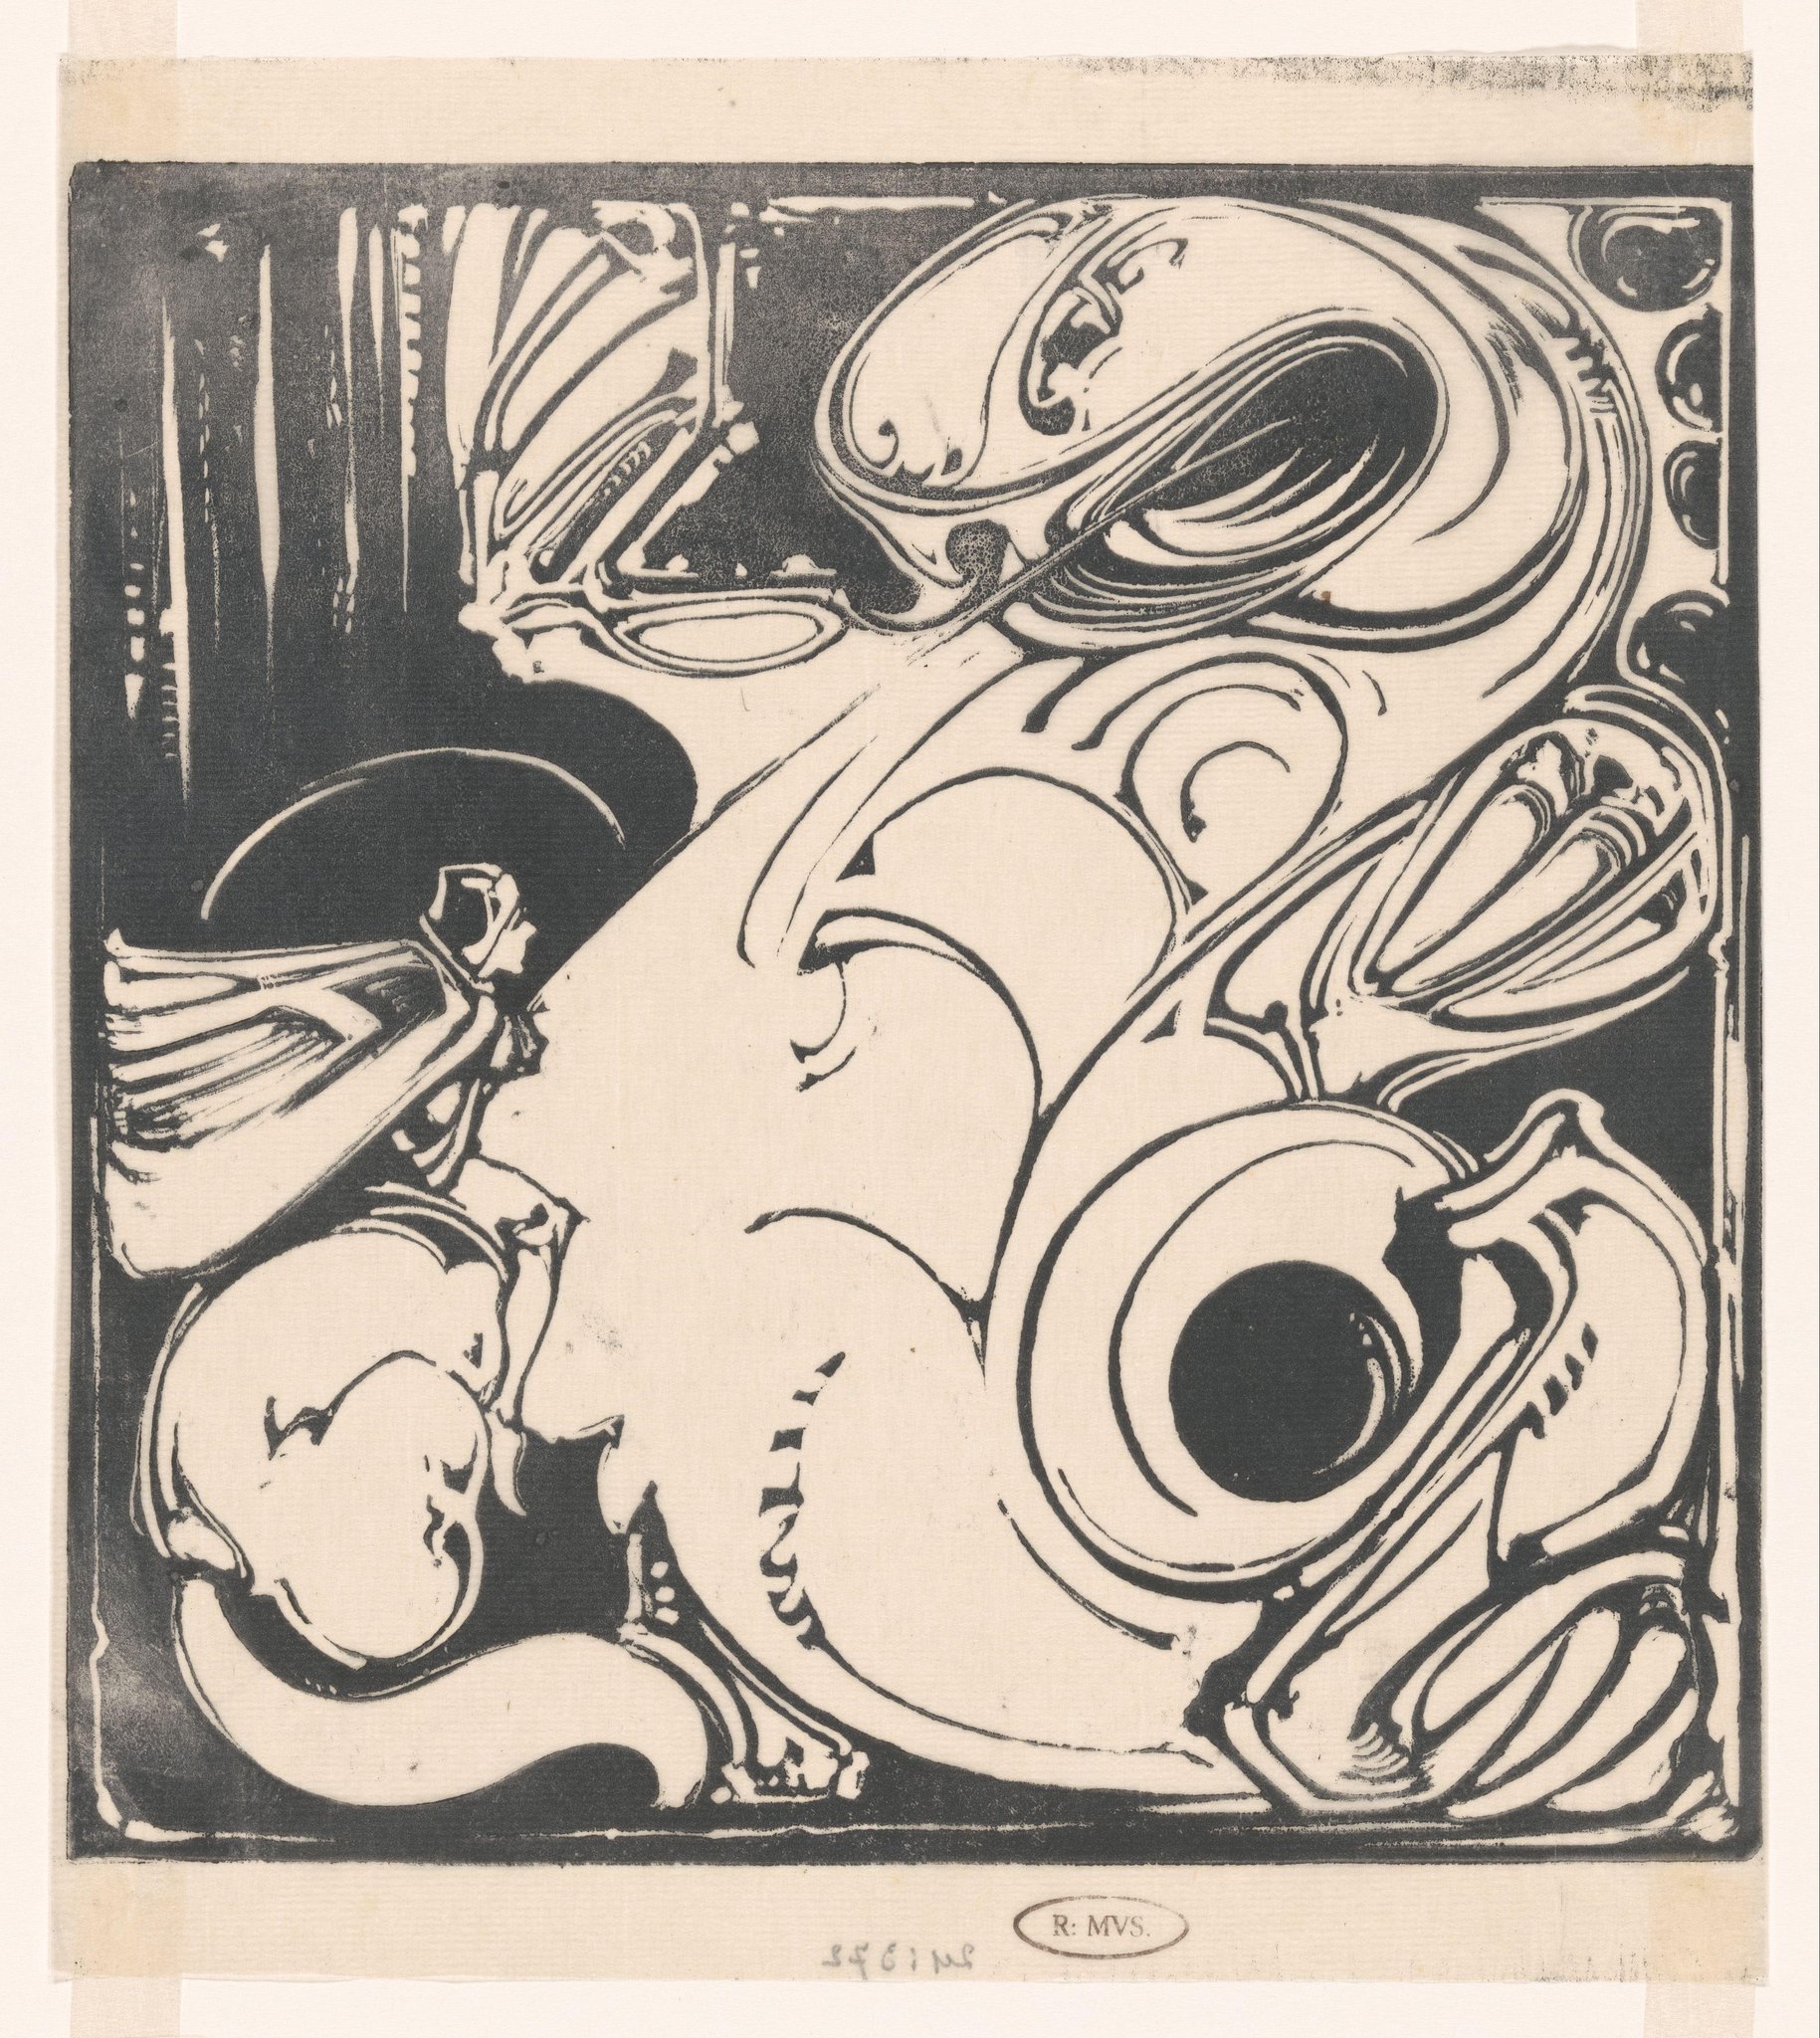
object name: print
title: St. Joris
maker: bernard willem wierink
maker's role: draughtsman, print maker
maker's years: 1856-1939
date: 1920-1923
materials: paper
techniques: relief print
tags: the warrior martyr george (georgius); possible attributes: banner (red cross on white field), (red) cross, dragon, (white) horse, broken lance, shield (with cross), sword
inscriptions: collector's mark: Lugt 2228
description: Deze prent is vermoedelijk een plaatsnede, ook al wordt in de literatuur veelal gesproken over een houtsnede. Voor zover Wierink zijn prenten in hoogdruk zelf nader heeft omschreven, heeft hij altijd de term 'plaatsnede' gebruikt.